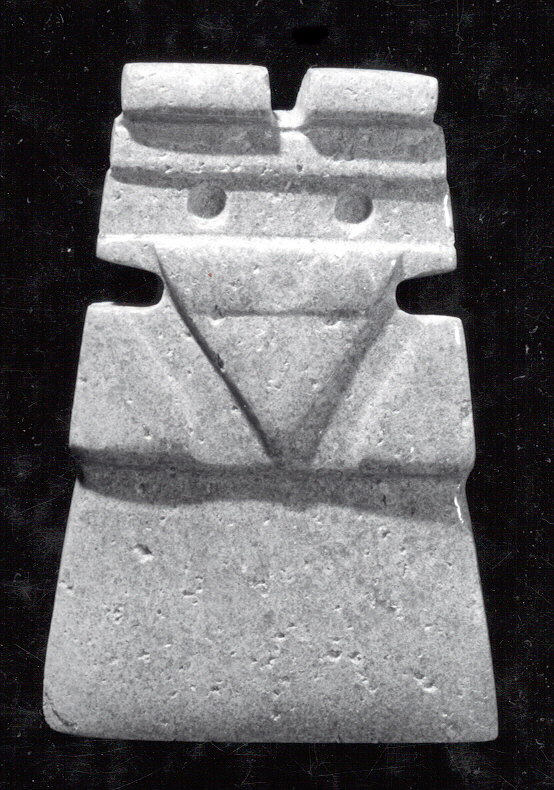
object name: pendant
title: Bird-celt Pendant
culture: guanacaste-nicoya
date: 401-1200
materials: jade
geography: costa rica